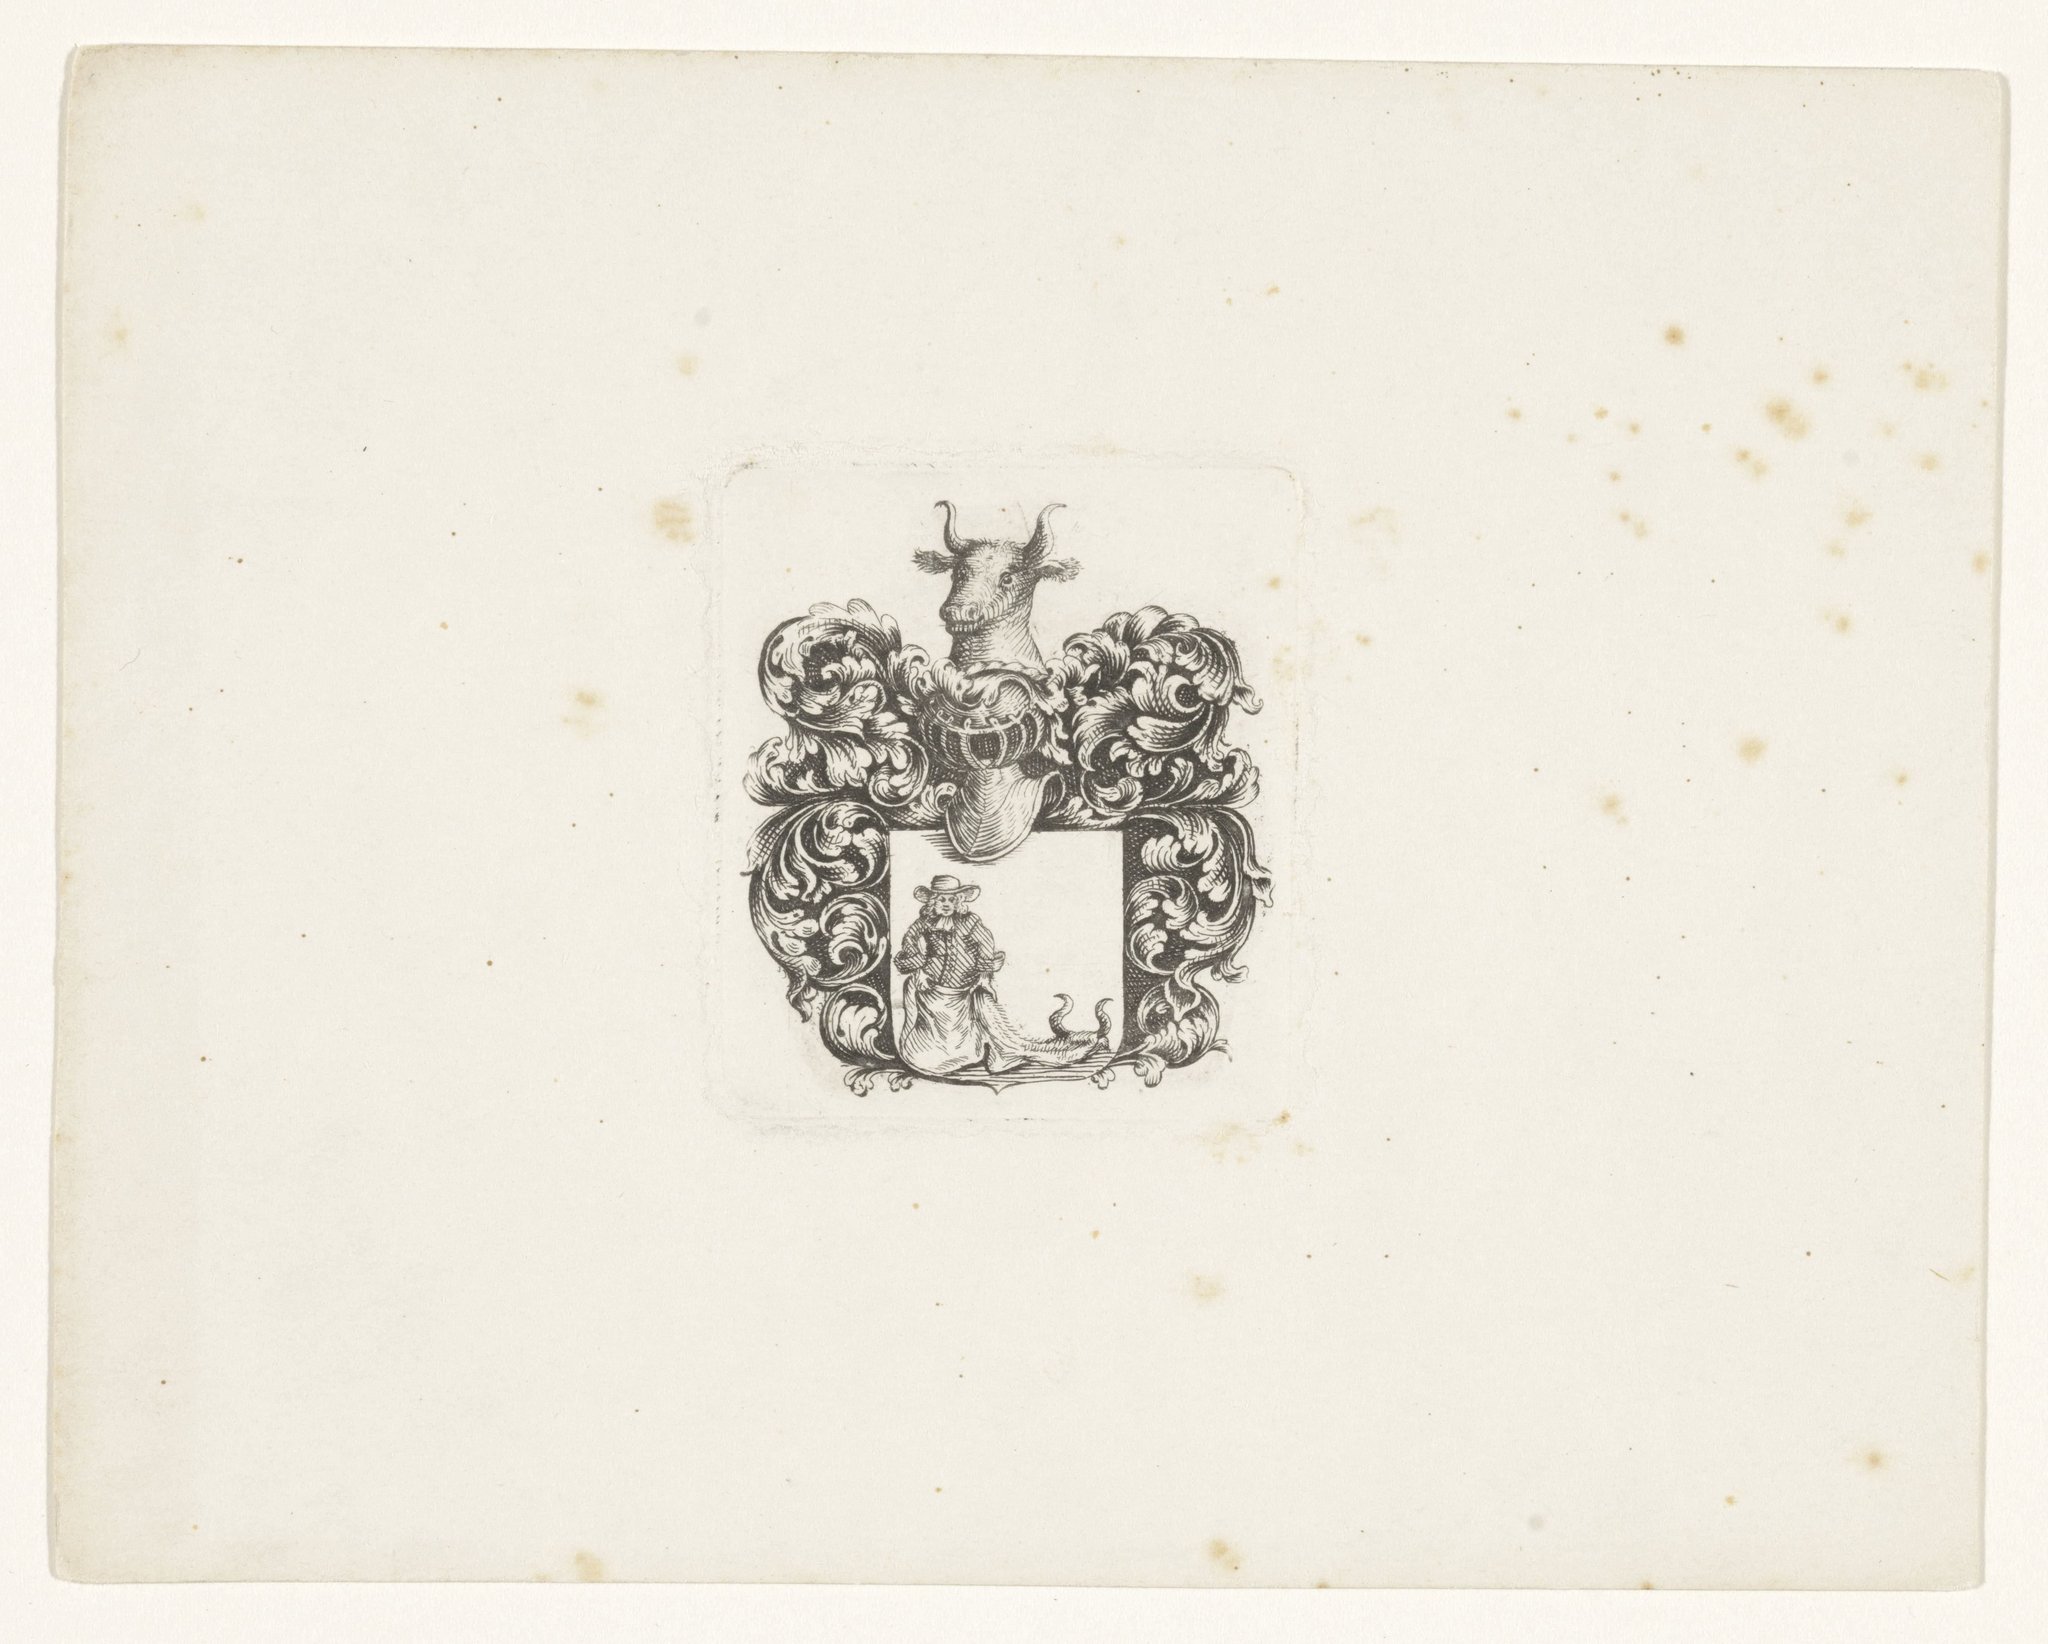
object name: print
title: Wapen van het Amsterdamse looiersgilde (?)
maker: Anonymous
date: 1650-1750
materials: paper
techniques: engraving, etching